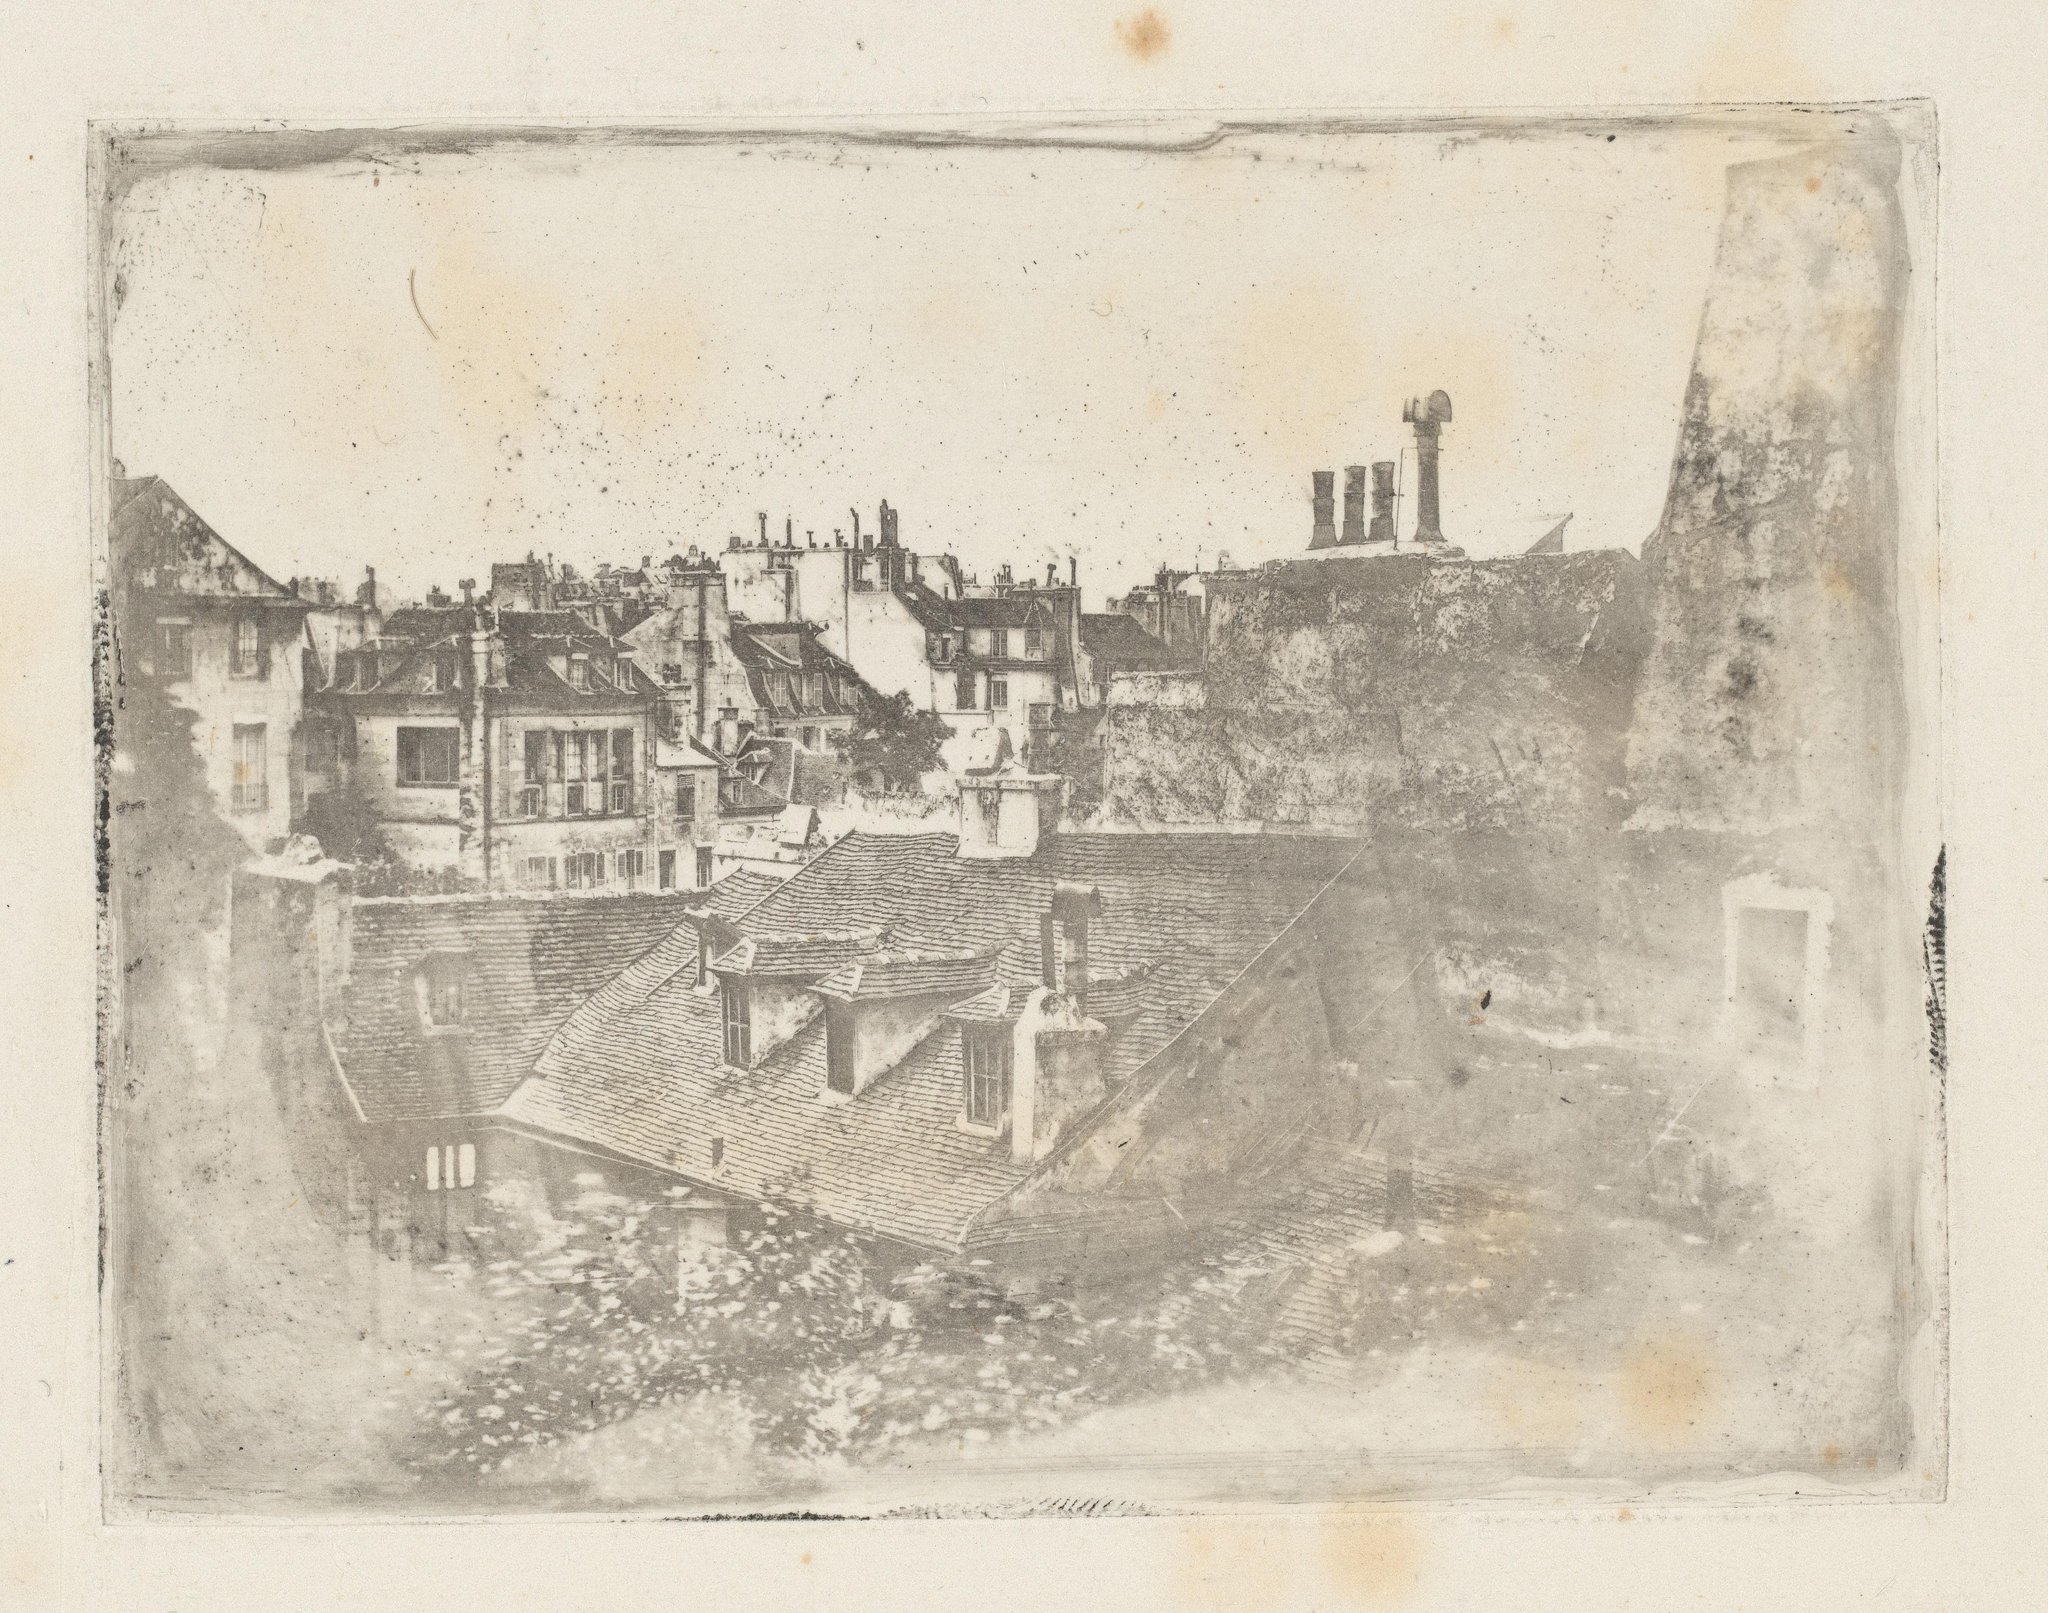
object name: photograph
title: View from Hippolyte Fizeau’s Window in Paris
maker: hippolyte fizeau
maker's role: physicist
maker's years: 1819-1896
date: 1842-1843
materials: paper, ink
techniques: etched daguerreotype print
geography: paris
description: This paper print is special. Approximately the same view (the roof with the three skylights) can be seen mirrored in the adjacent daguerreotype. In the early days of photography, making prints from daguerreotypes was not yet feasible. Hippolyte Fizeau, however, attempted to achieve precisely this by experimenting with an etching press. He made this print from an etched daguerreotype plate. The result was razor-sharp, but the tone was not yet uniform.